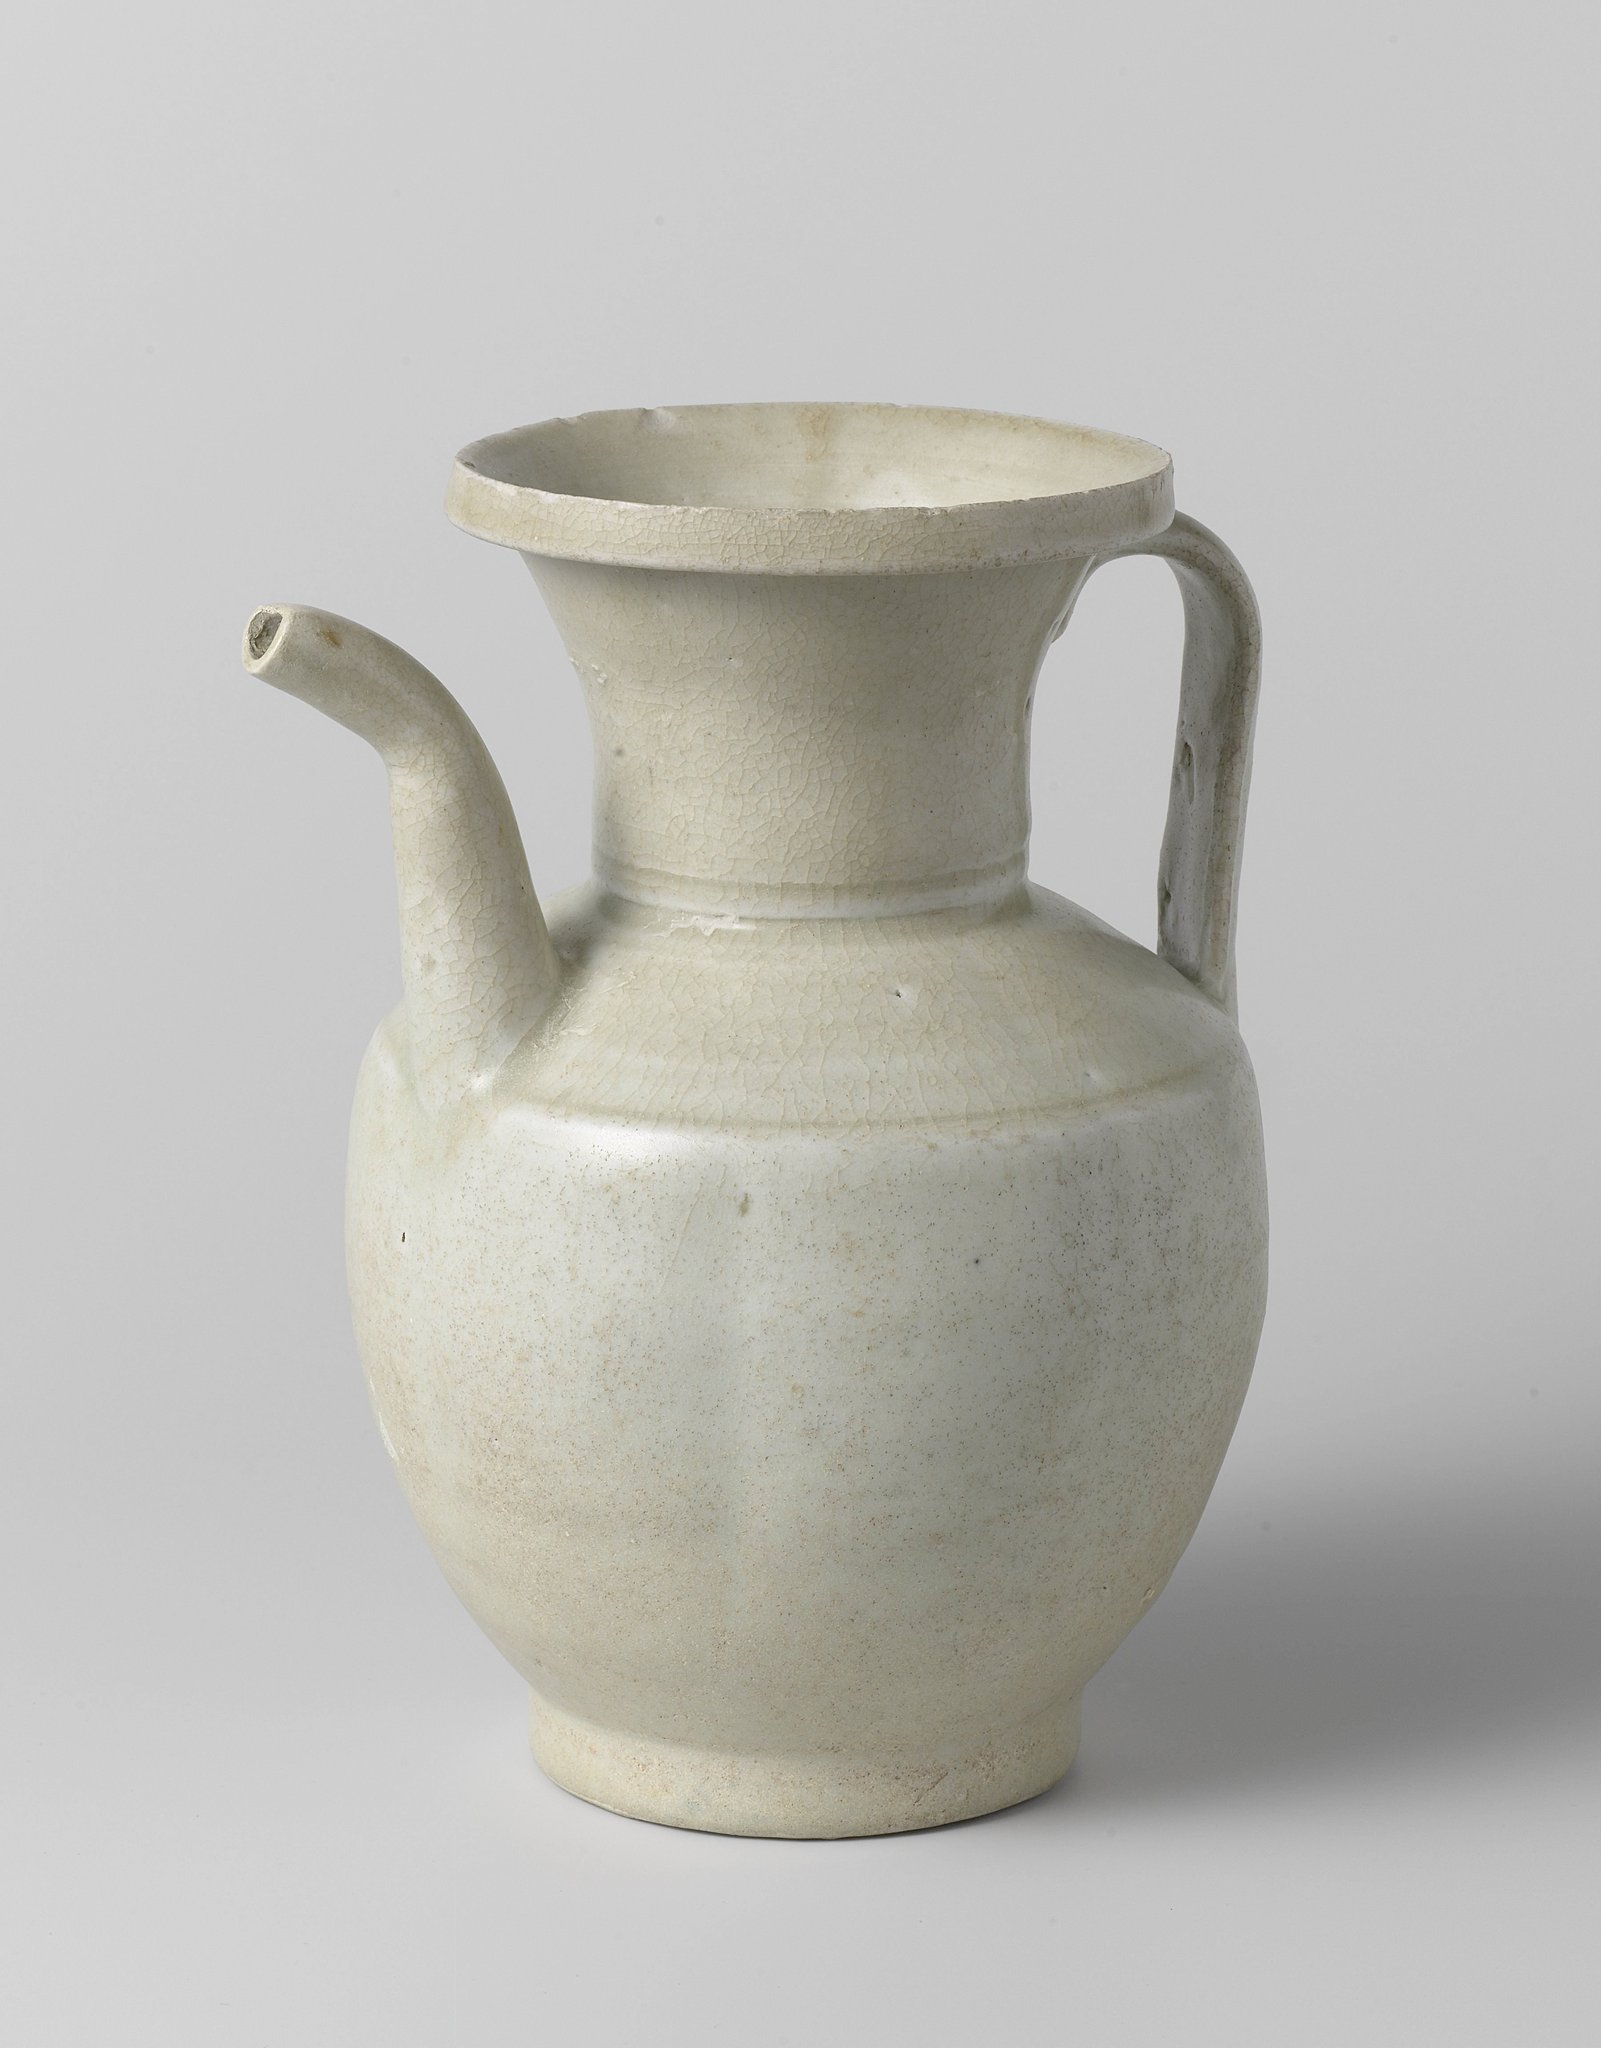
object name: ewer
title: Ewer with fluted sides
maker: Anonymous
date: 900-999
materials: earthenware, glaze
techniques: firing, forming, turning, vitrification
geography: china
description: Kan van aardewerk met een geribde buik en een brede, uitlopende hals, bedekt met een grijsgroen glazuur. Geknikte tuit vanuit de schouder; het oor vanuit de schouder verbonden met de rand. Het glazuur is enigszins aangetast. Een barst vanuit de voet naar de buik. Een chip in de rand. Celadon[?].